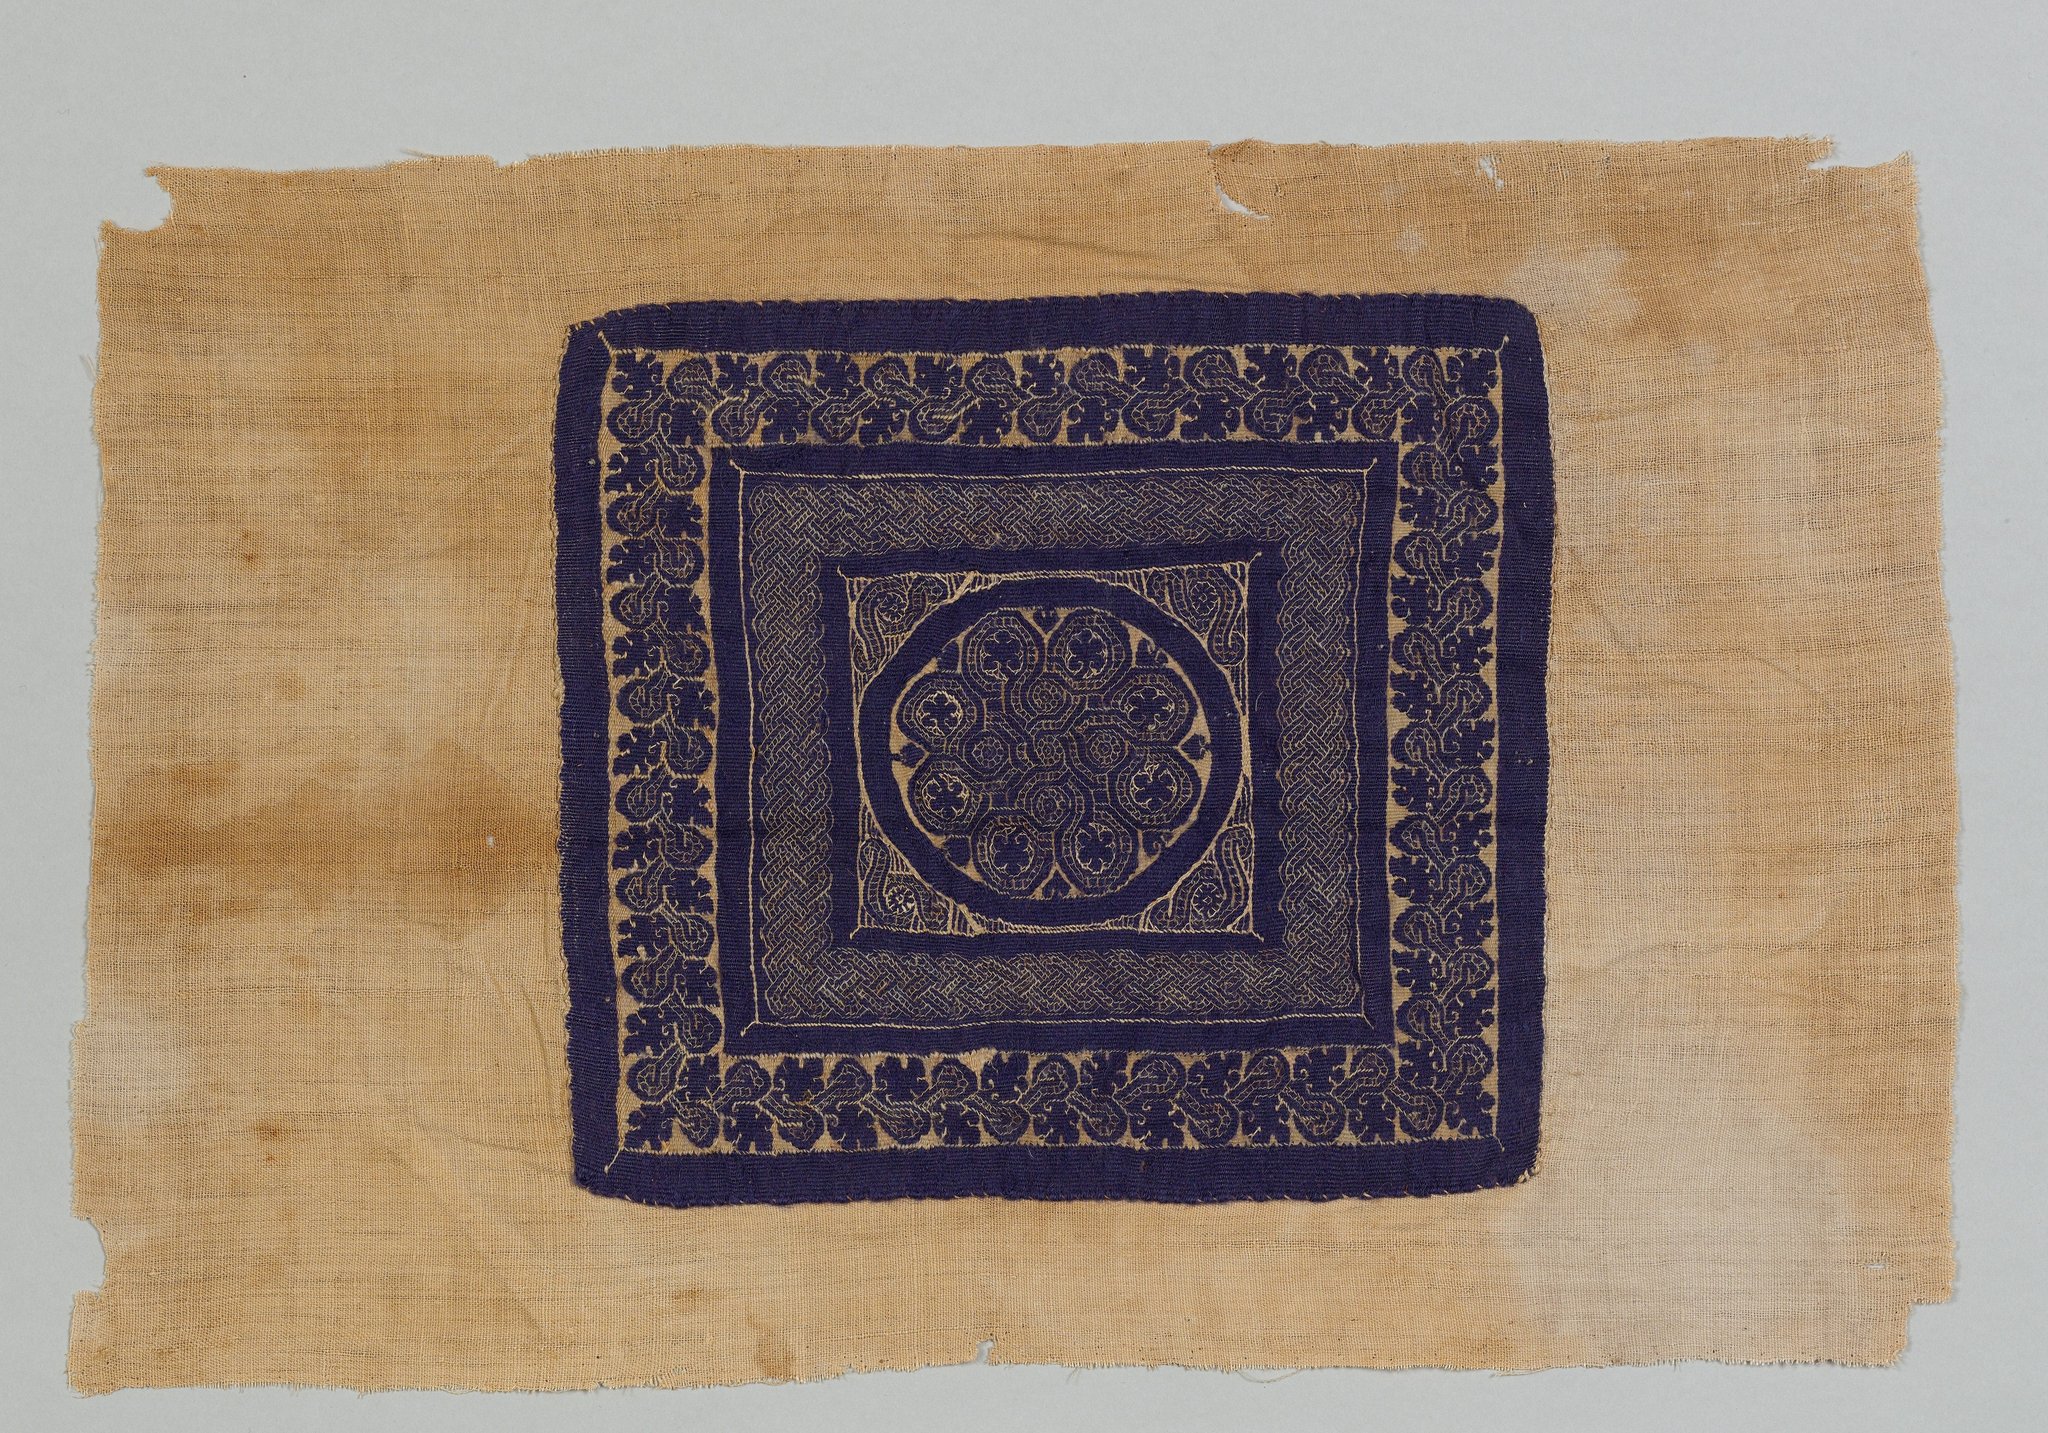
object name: textile fragment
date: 201-400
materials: linen, wool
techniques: weave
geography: egypt